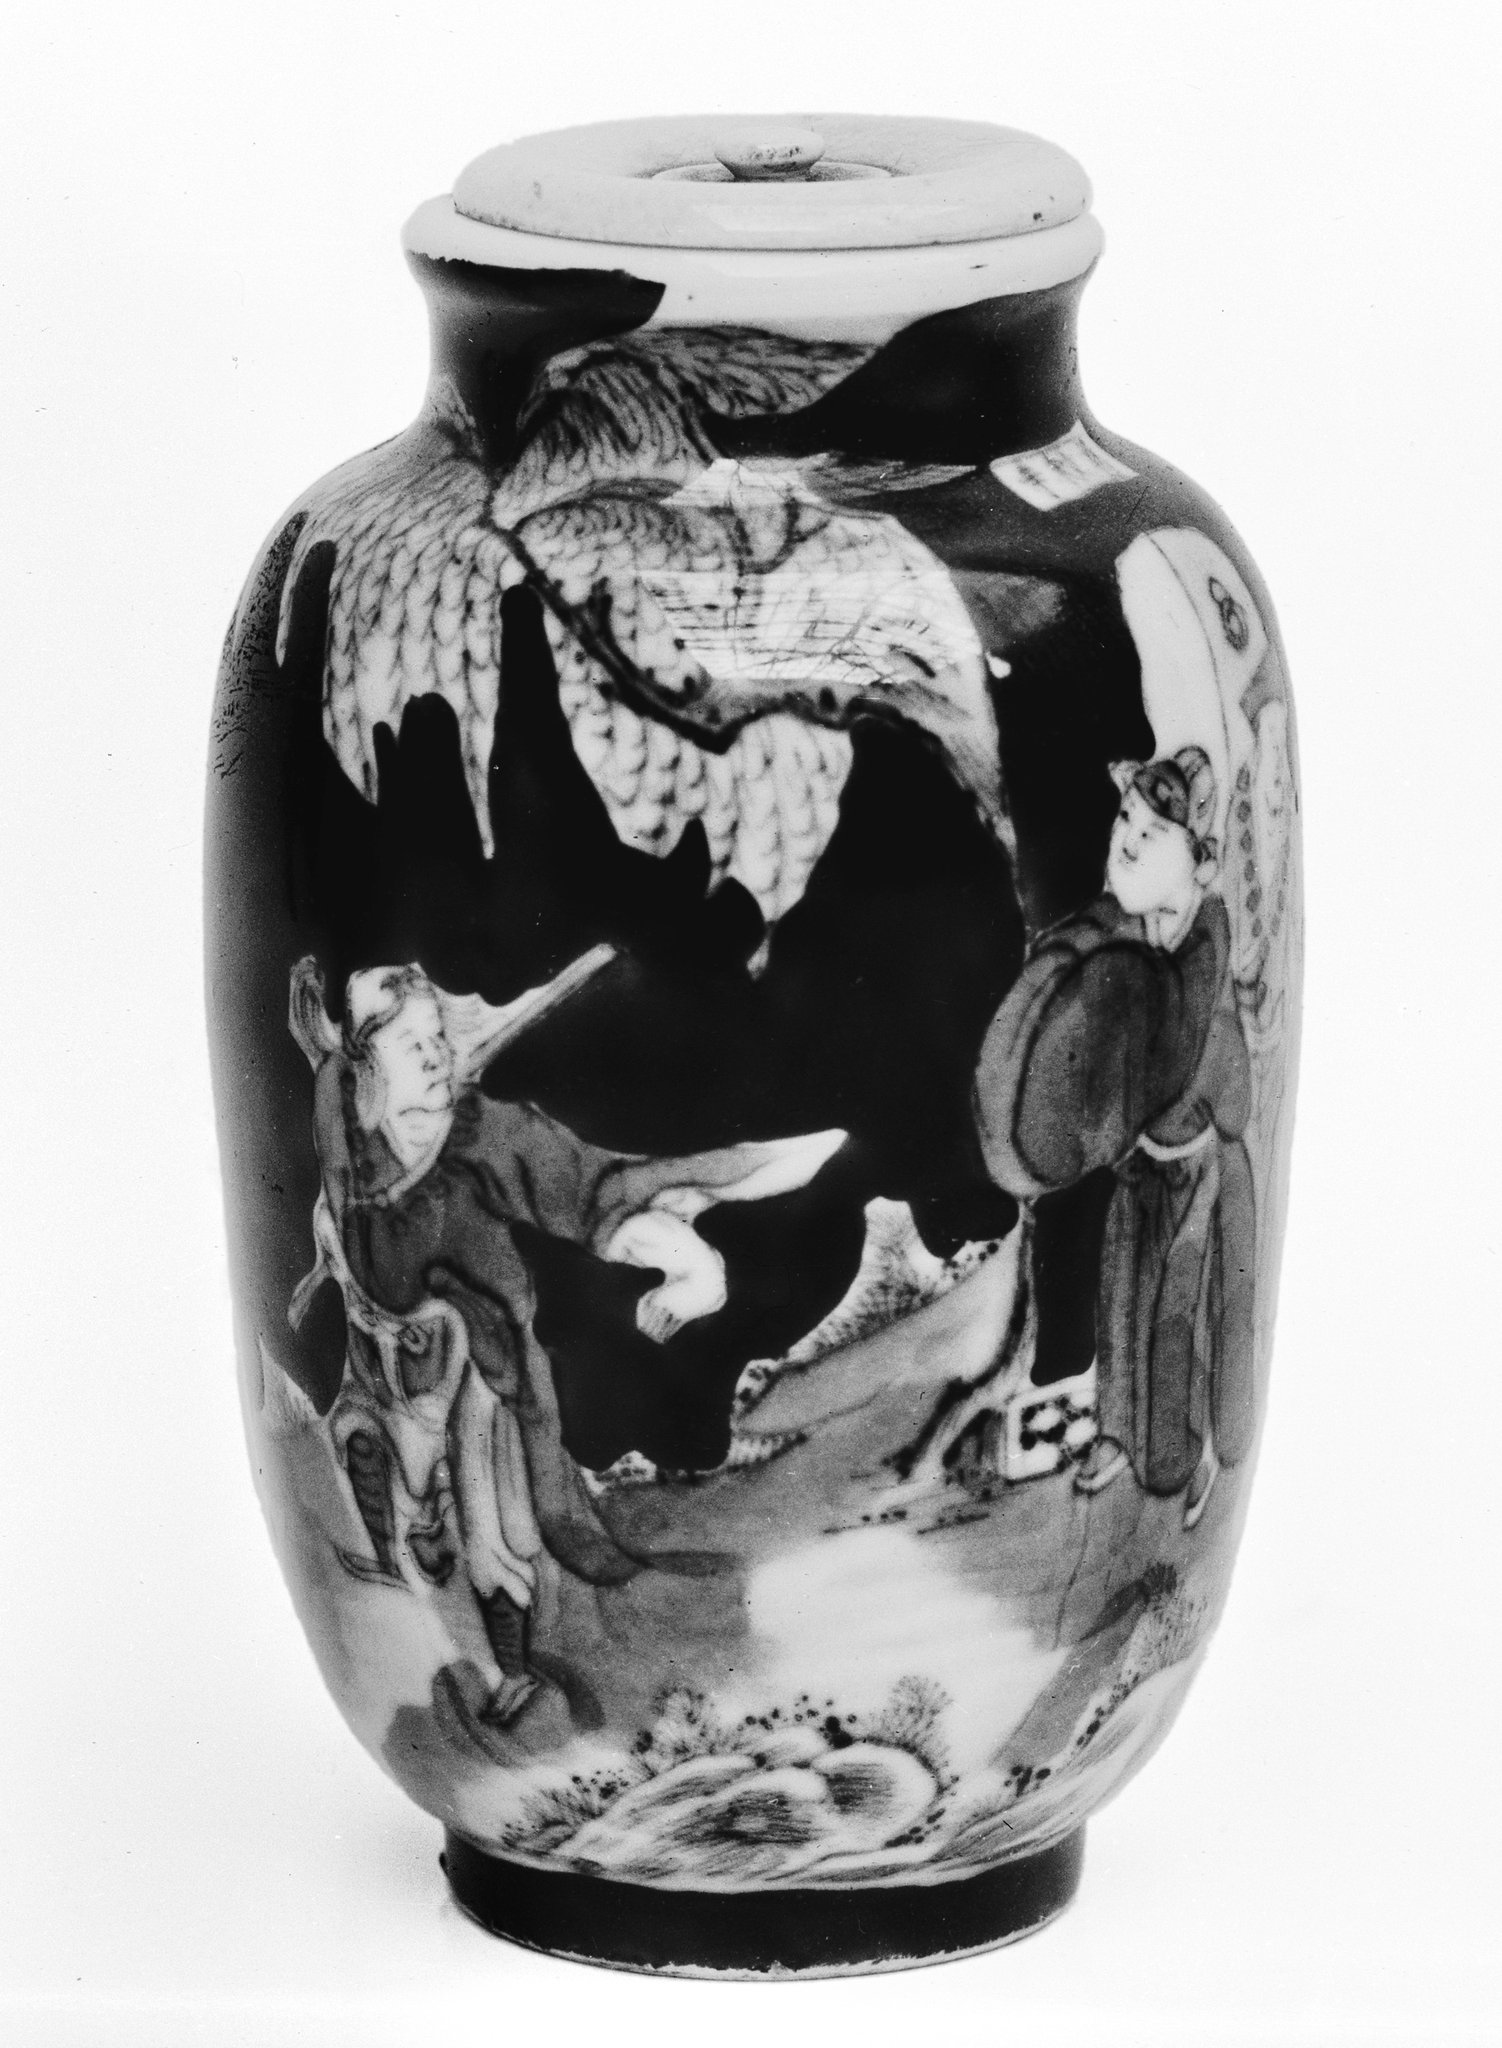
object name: minature bottle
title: Minature bottle with scene of the West Chamber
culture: chinese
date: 1801-1900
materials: cobalt, enamel, porcelain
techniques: overglaze, painting, underglaze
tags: men